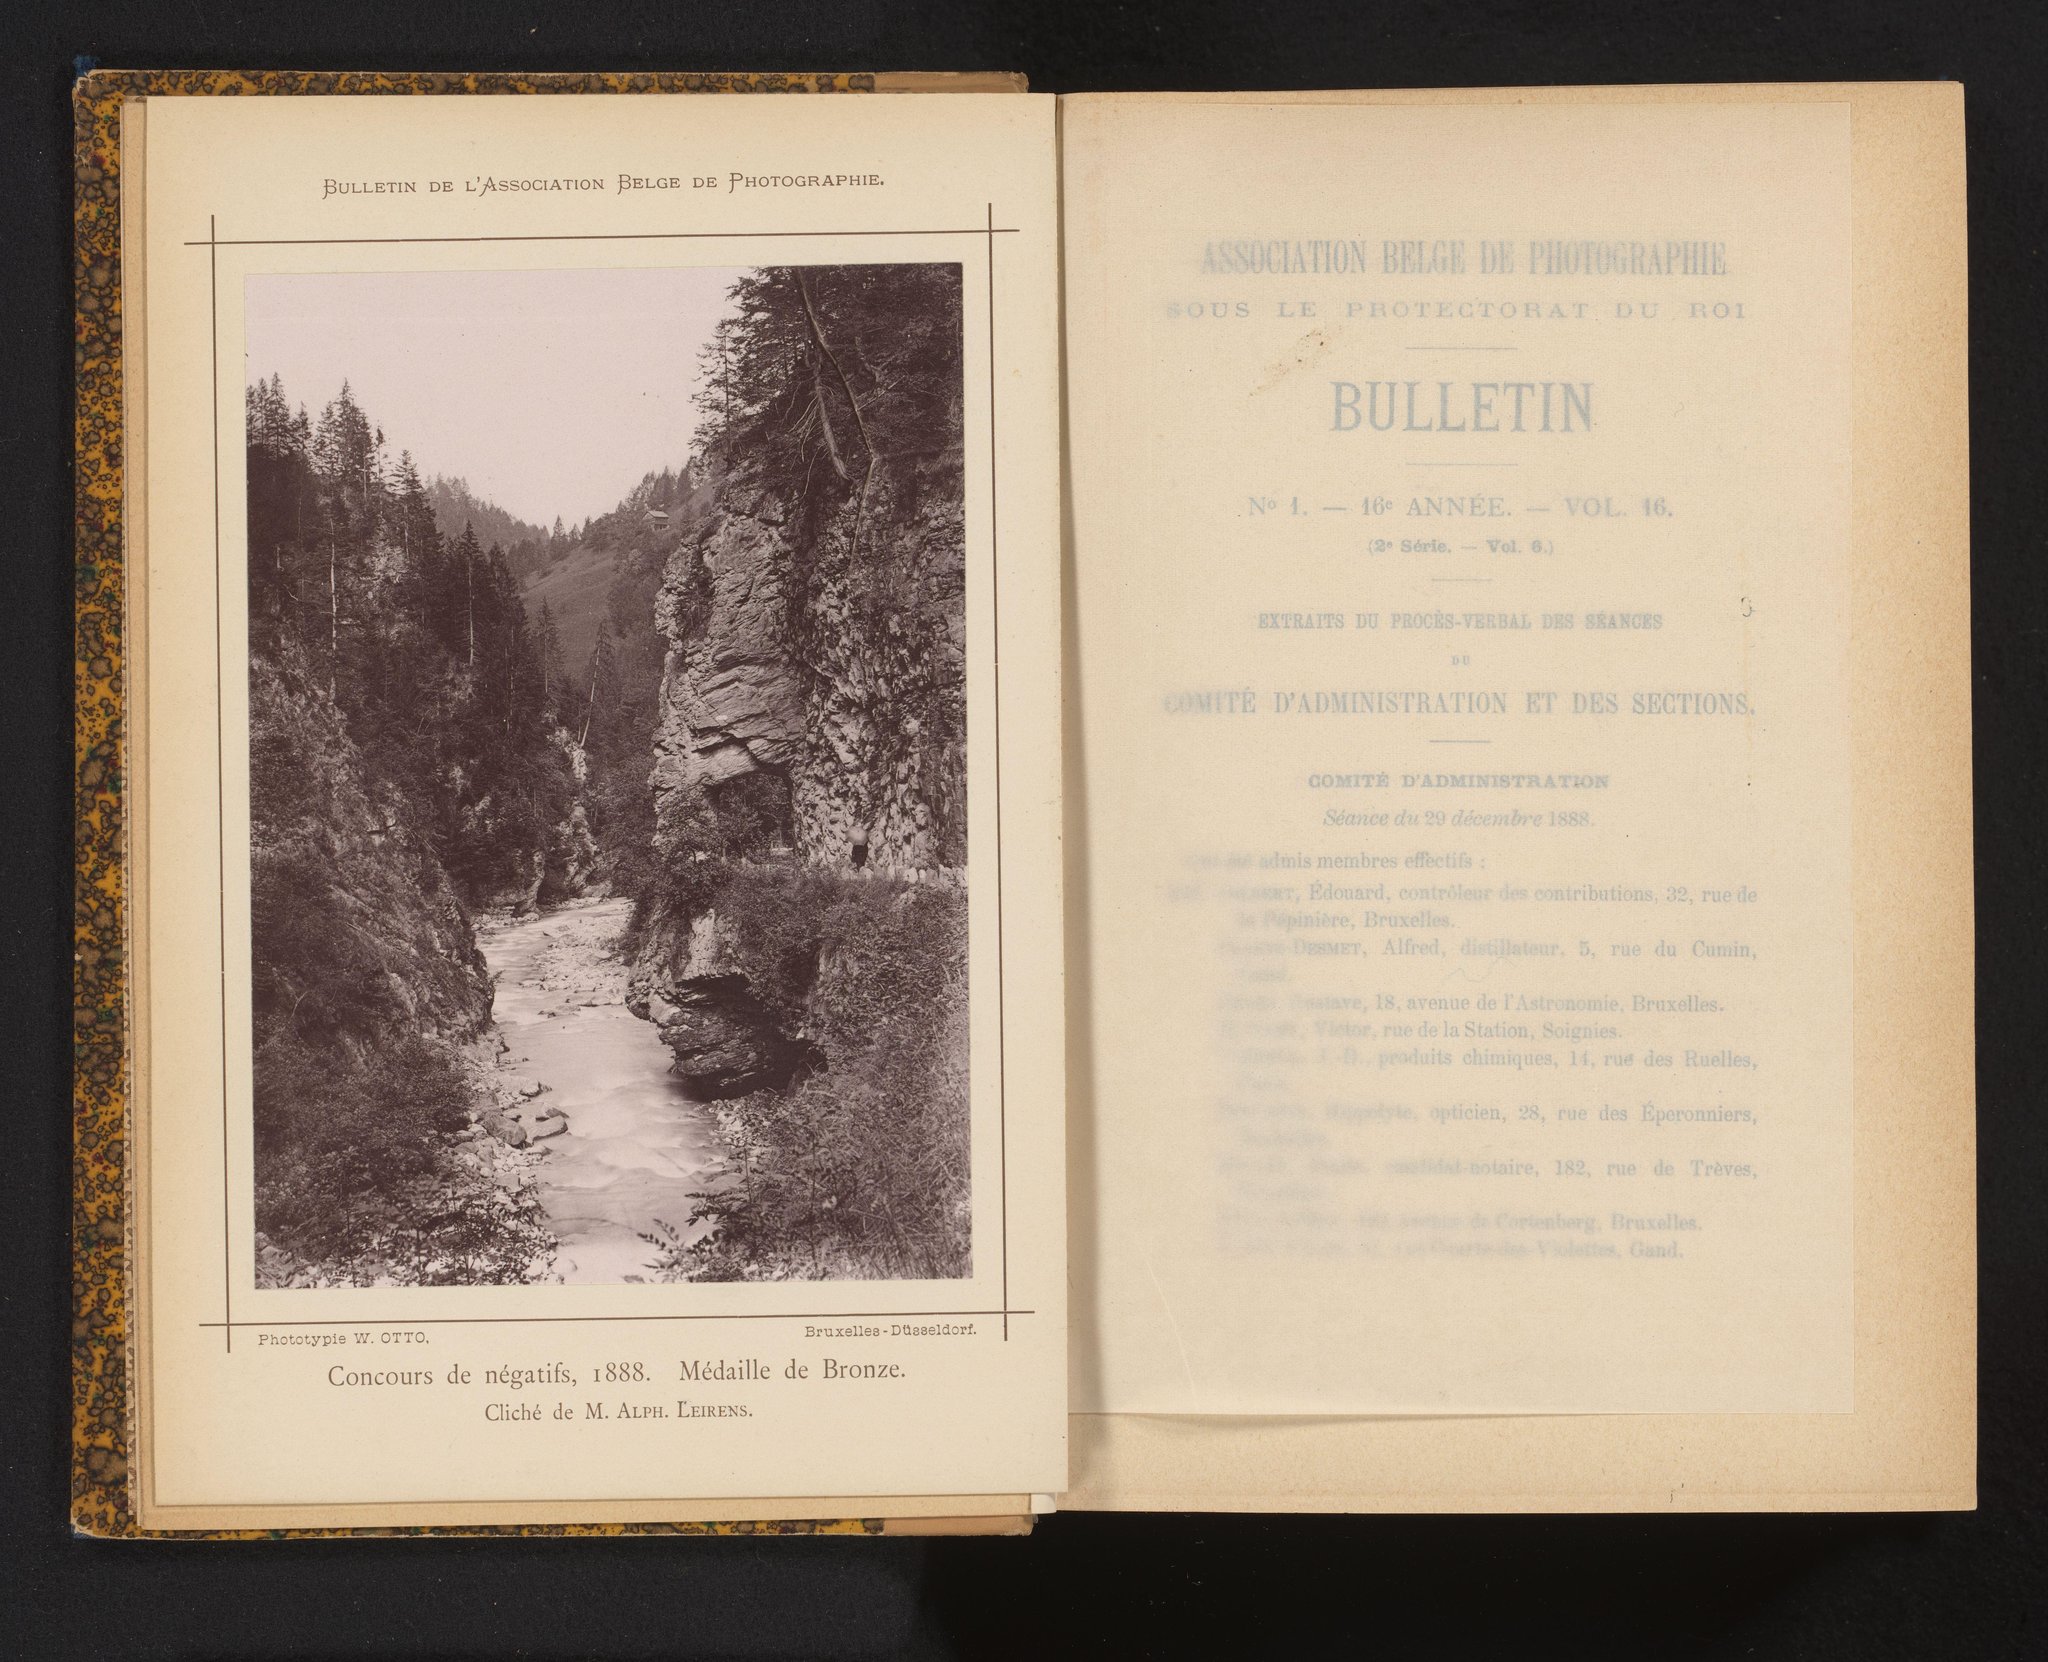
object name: page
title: Rotspartijen in het dal van de Tamina, Zwitserland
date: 1886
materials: cardboard, paper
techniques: photograph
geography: taminakloof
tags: brook, rock-formations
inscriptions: inscription: ‘Concours de négatifs, 1888. Médaille de Bronze.’